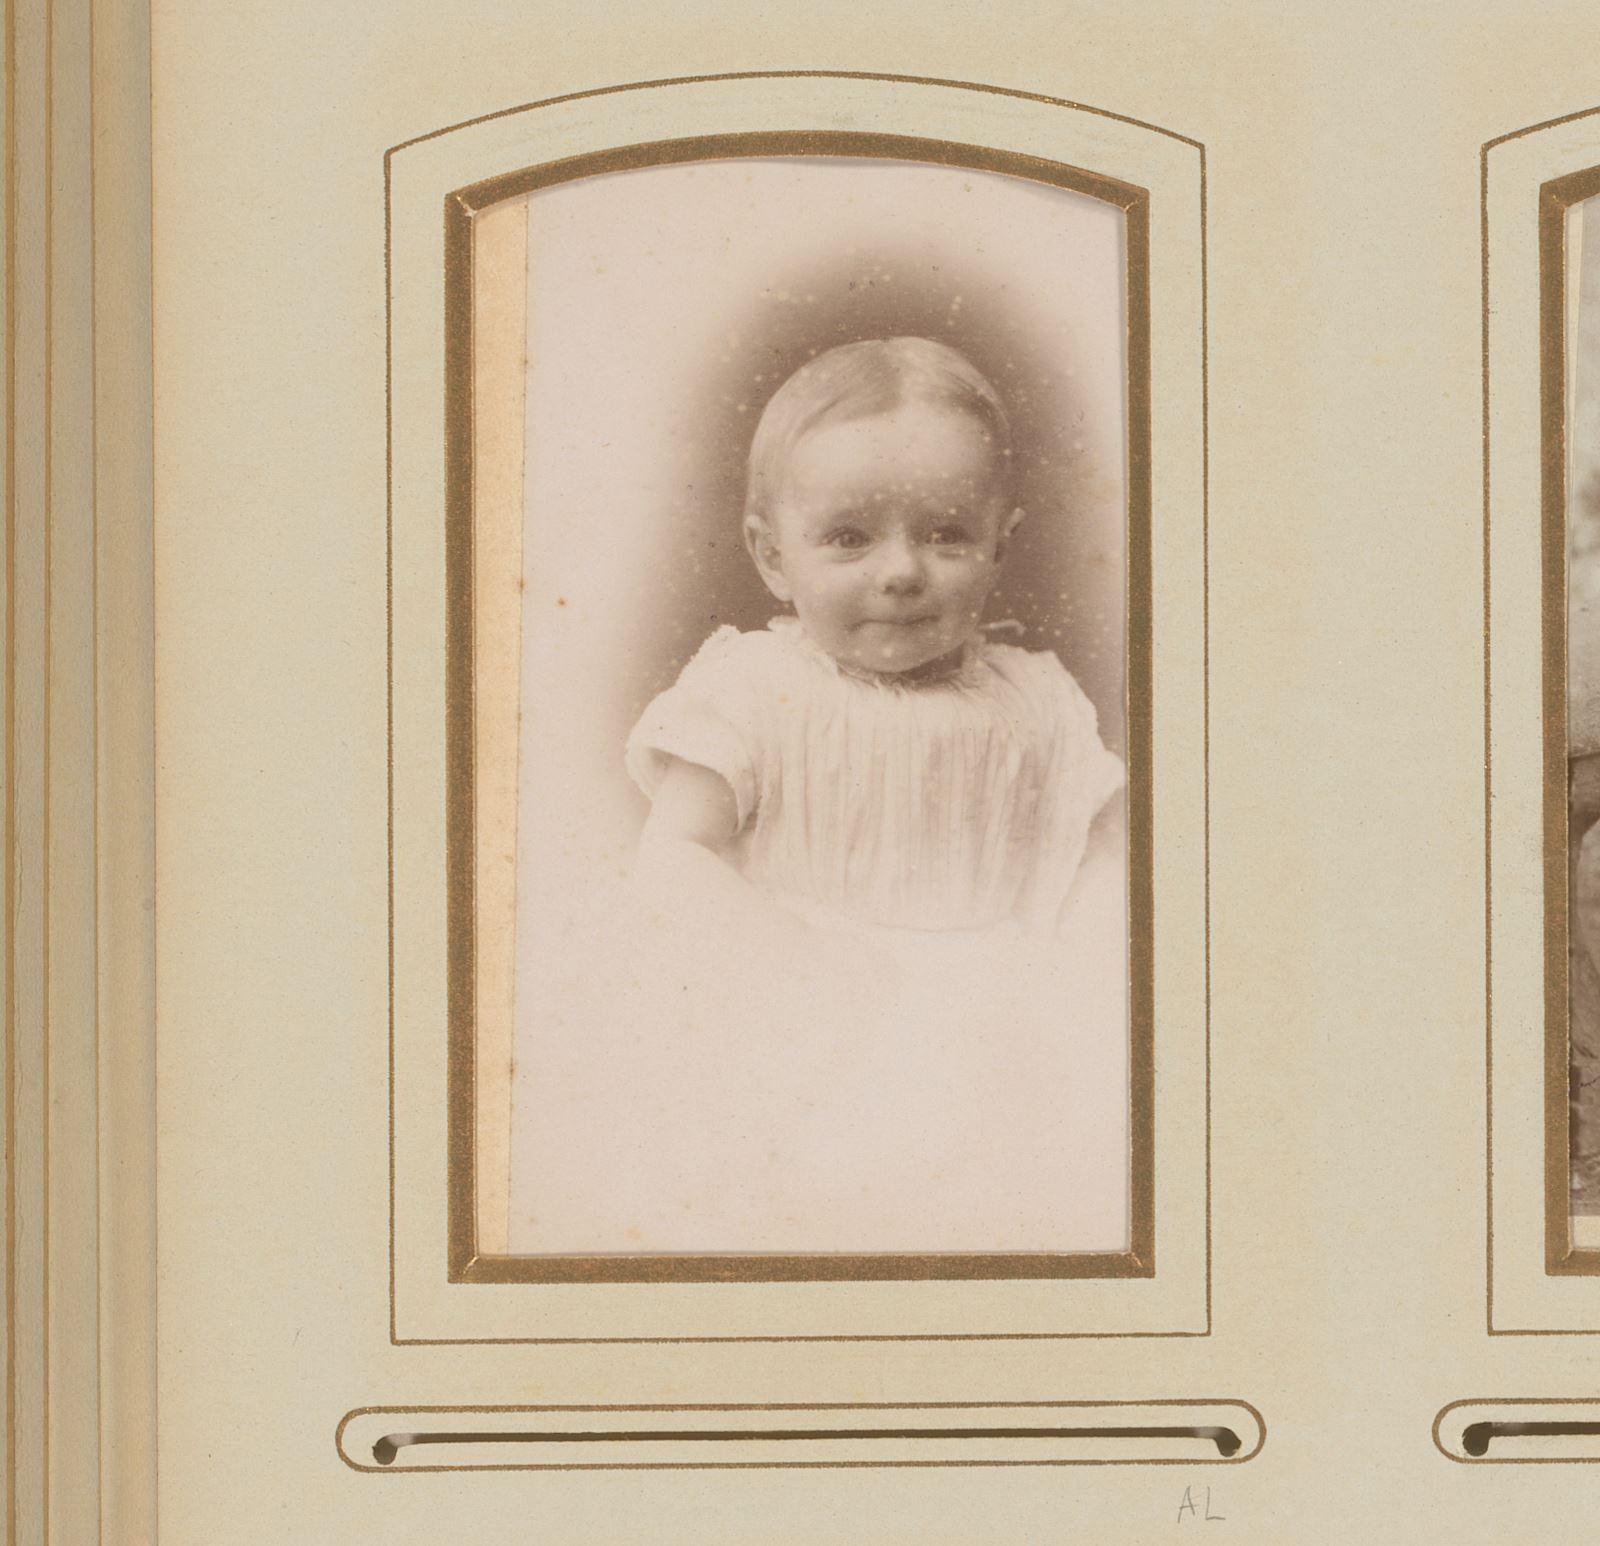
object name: album leaf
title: Portret van een meisje in witte jurk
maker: b.j. pottjewijd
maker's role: fotograaf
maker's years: 1859-1941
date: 1880-1920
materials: cardboard, photographic support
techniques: collodion silver print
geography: winschoten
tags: historical persons - bb - woman, toddler (female)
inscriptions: inscription: ‘B. J. Pottjewijd/ Winschoten/ Het negatief blijft voor/ nabestelling bewaard./ Vergrootingen in alle afmetingen.’